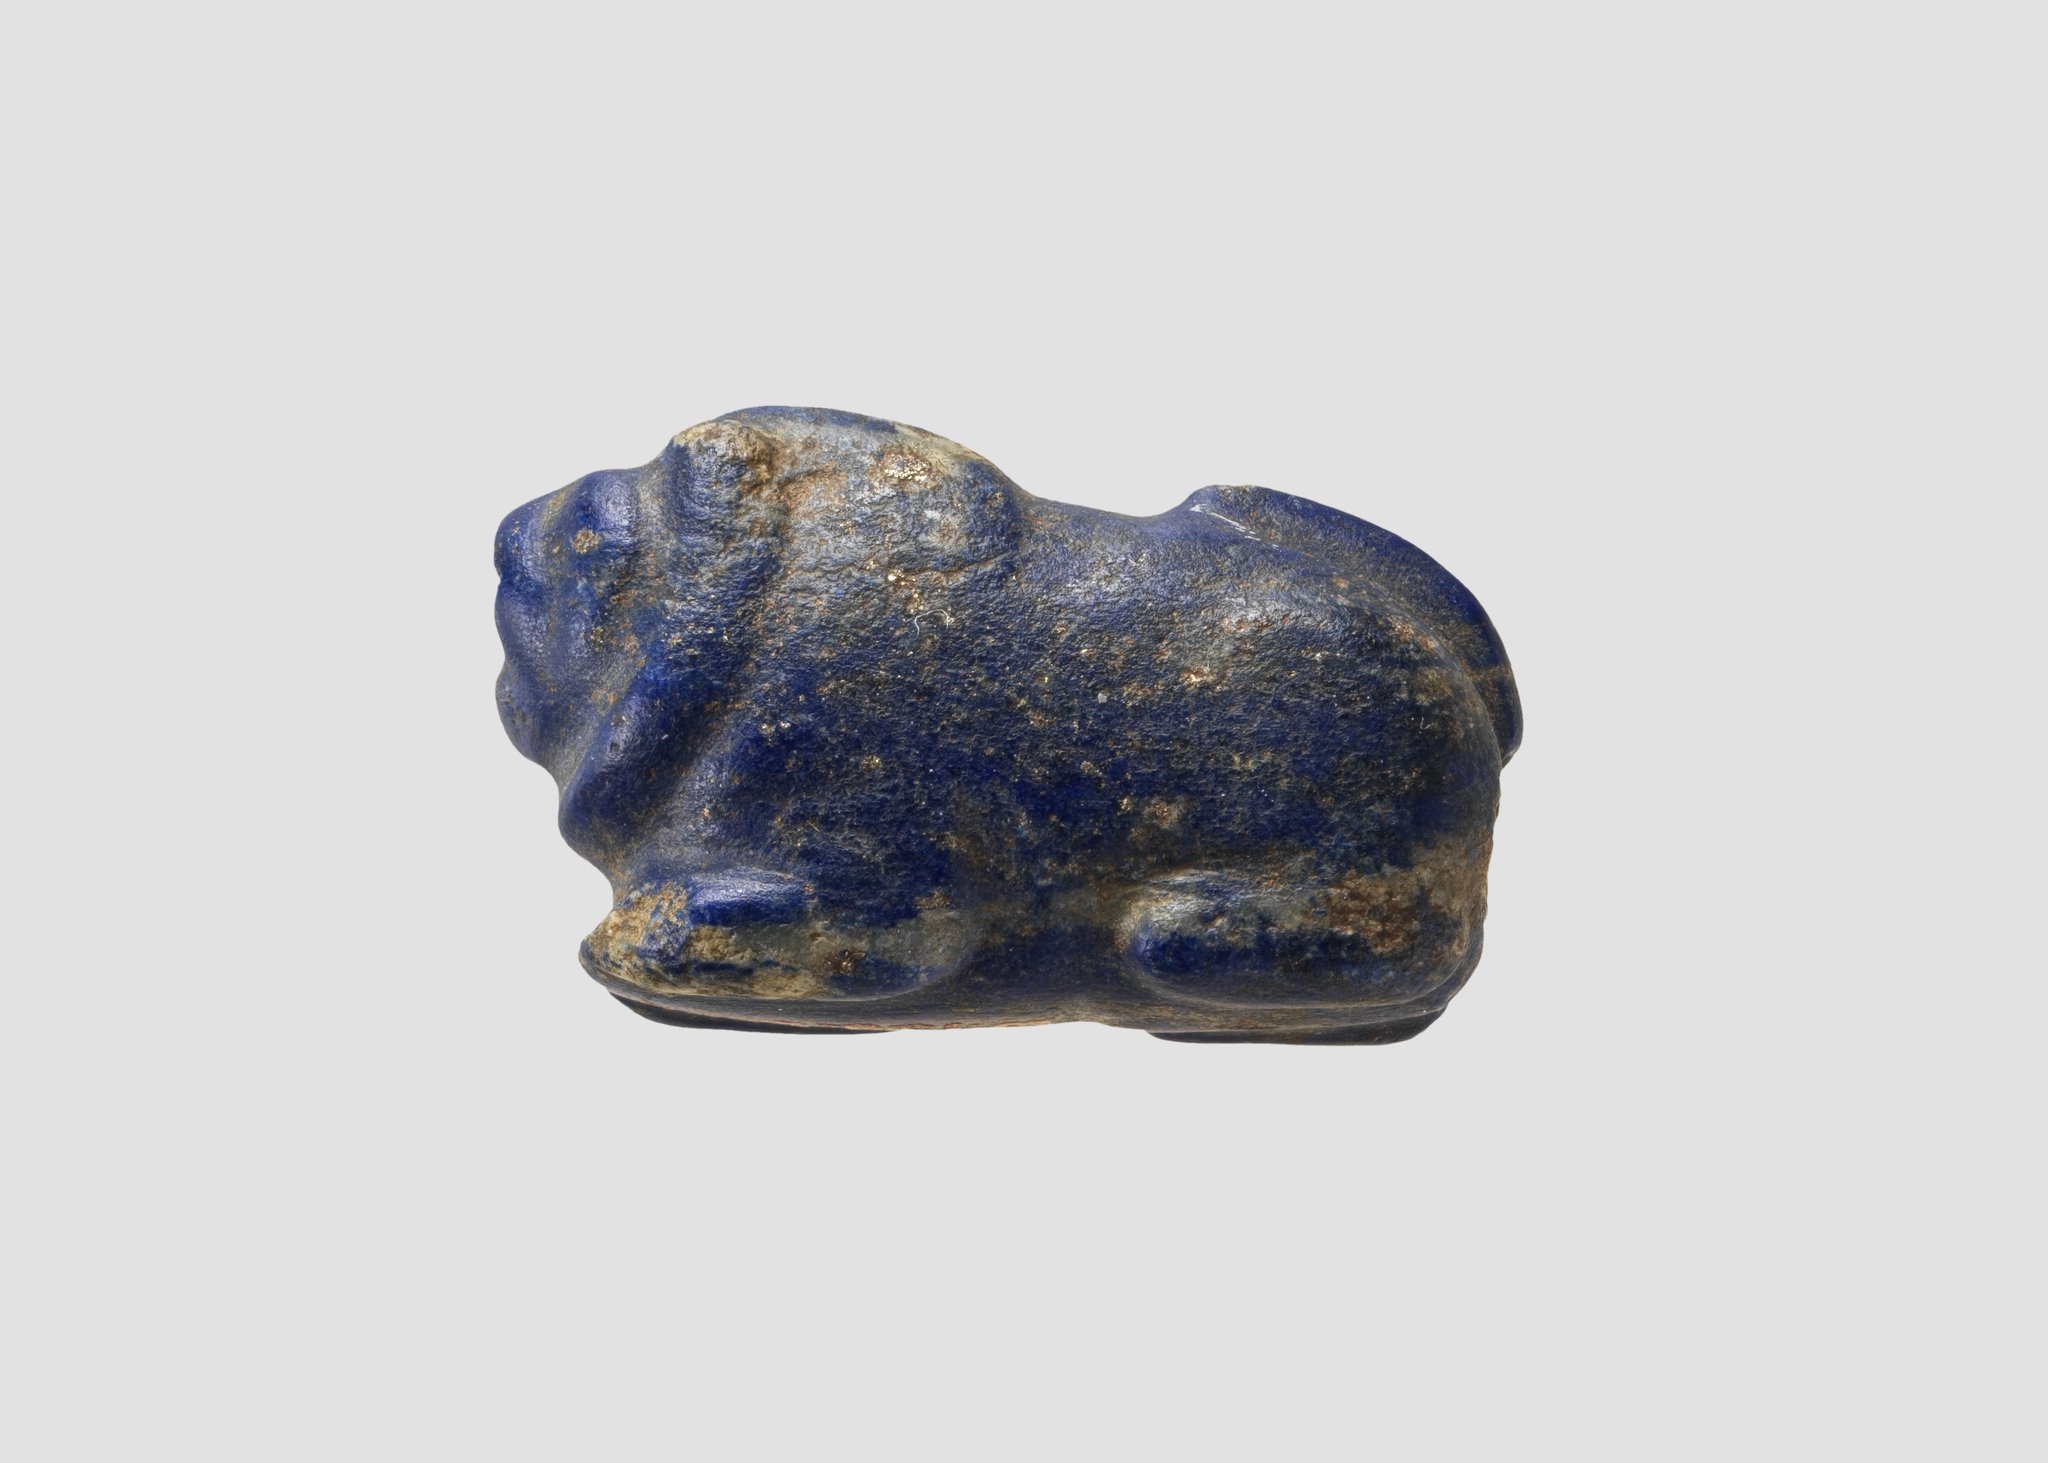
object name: necklace, bead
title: Amulet of a lion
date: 3300-2900 BCE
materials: lapis lazuli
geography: mesopotamia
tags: lions